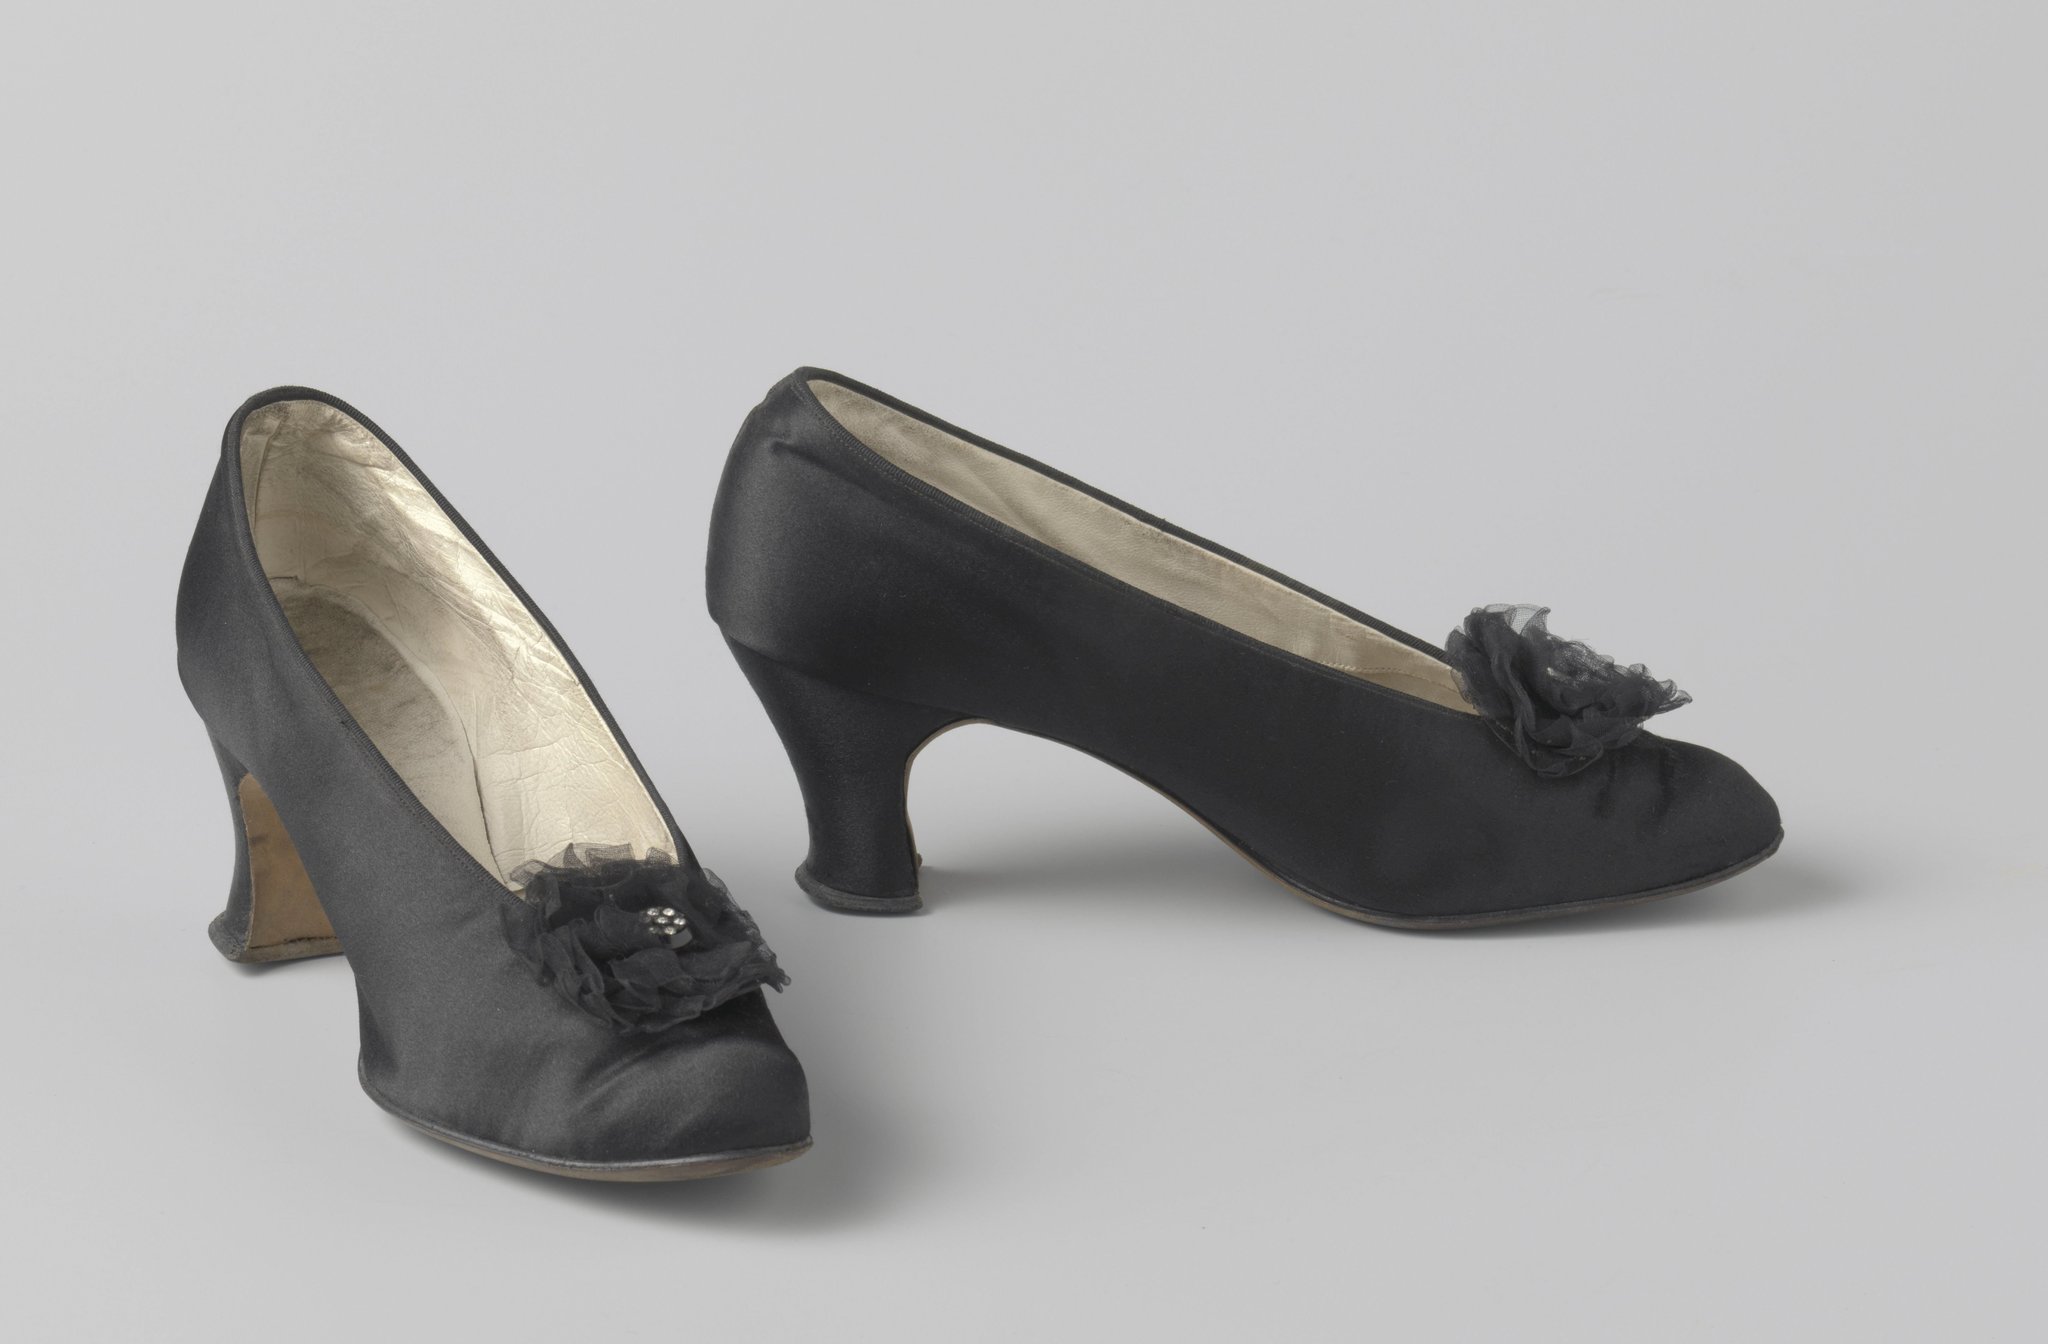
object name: womenswear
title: Schoen, pump, van zwart satijn met puntneus en laag uitgesneden voorblad, versierd met pompoentjes van zwart zijden gaas met knoop met zeven namaak diamanten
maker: Anonymous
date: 1915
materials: diamond, textile, silk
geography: brussels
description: Pump van zwart satijn. Puntneus. Uit één, laag uitgesneden (voor)blad. Matig hoge hak, middelzwaar, iets uitgehold. Gevoerd met wit glacéleer. Versierd met pompoentjes van zwart zijden gaas, waarop een zwart knoopje met zeven namaakdiamantjes.